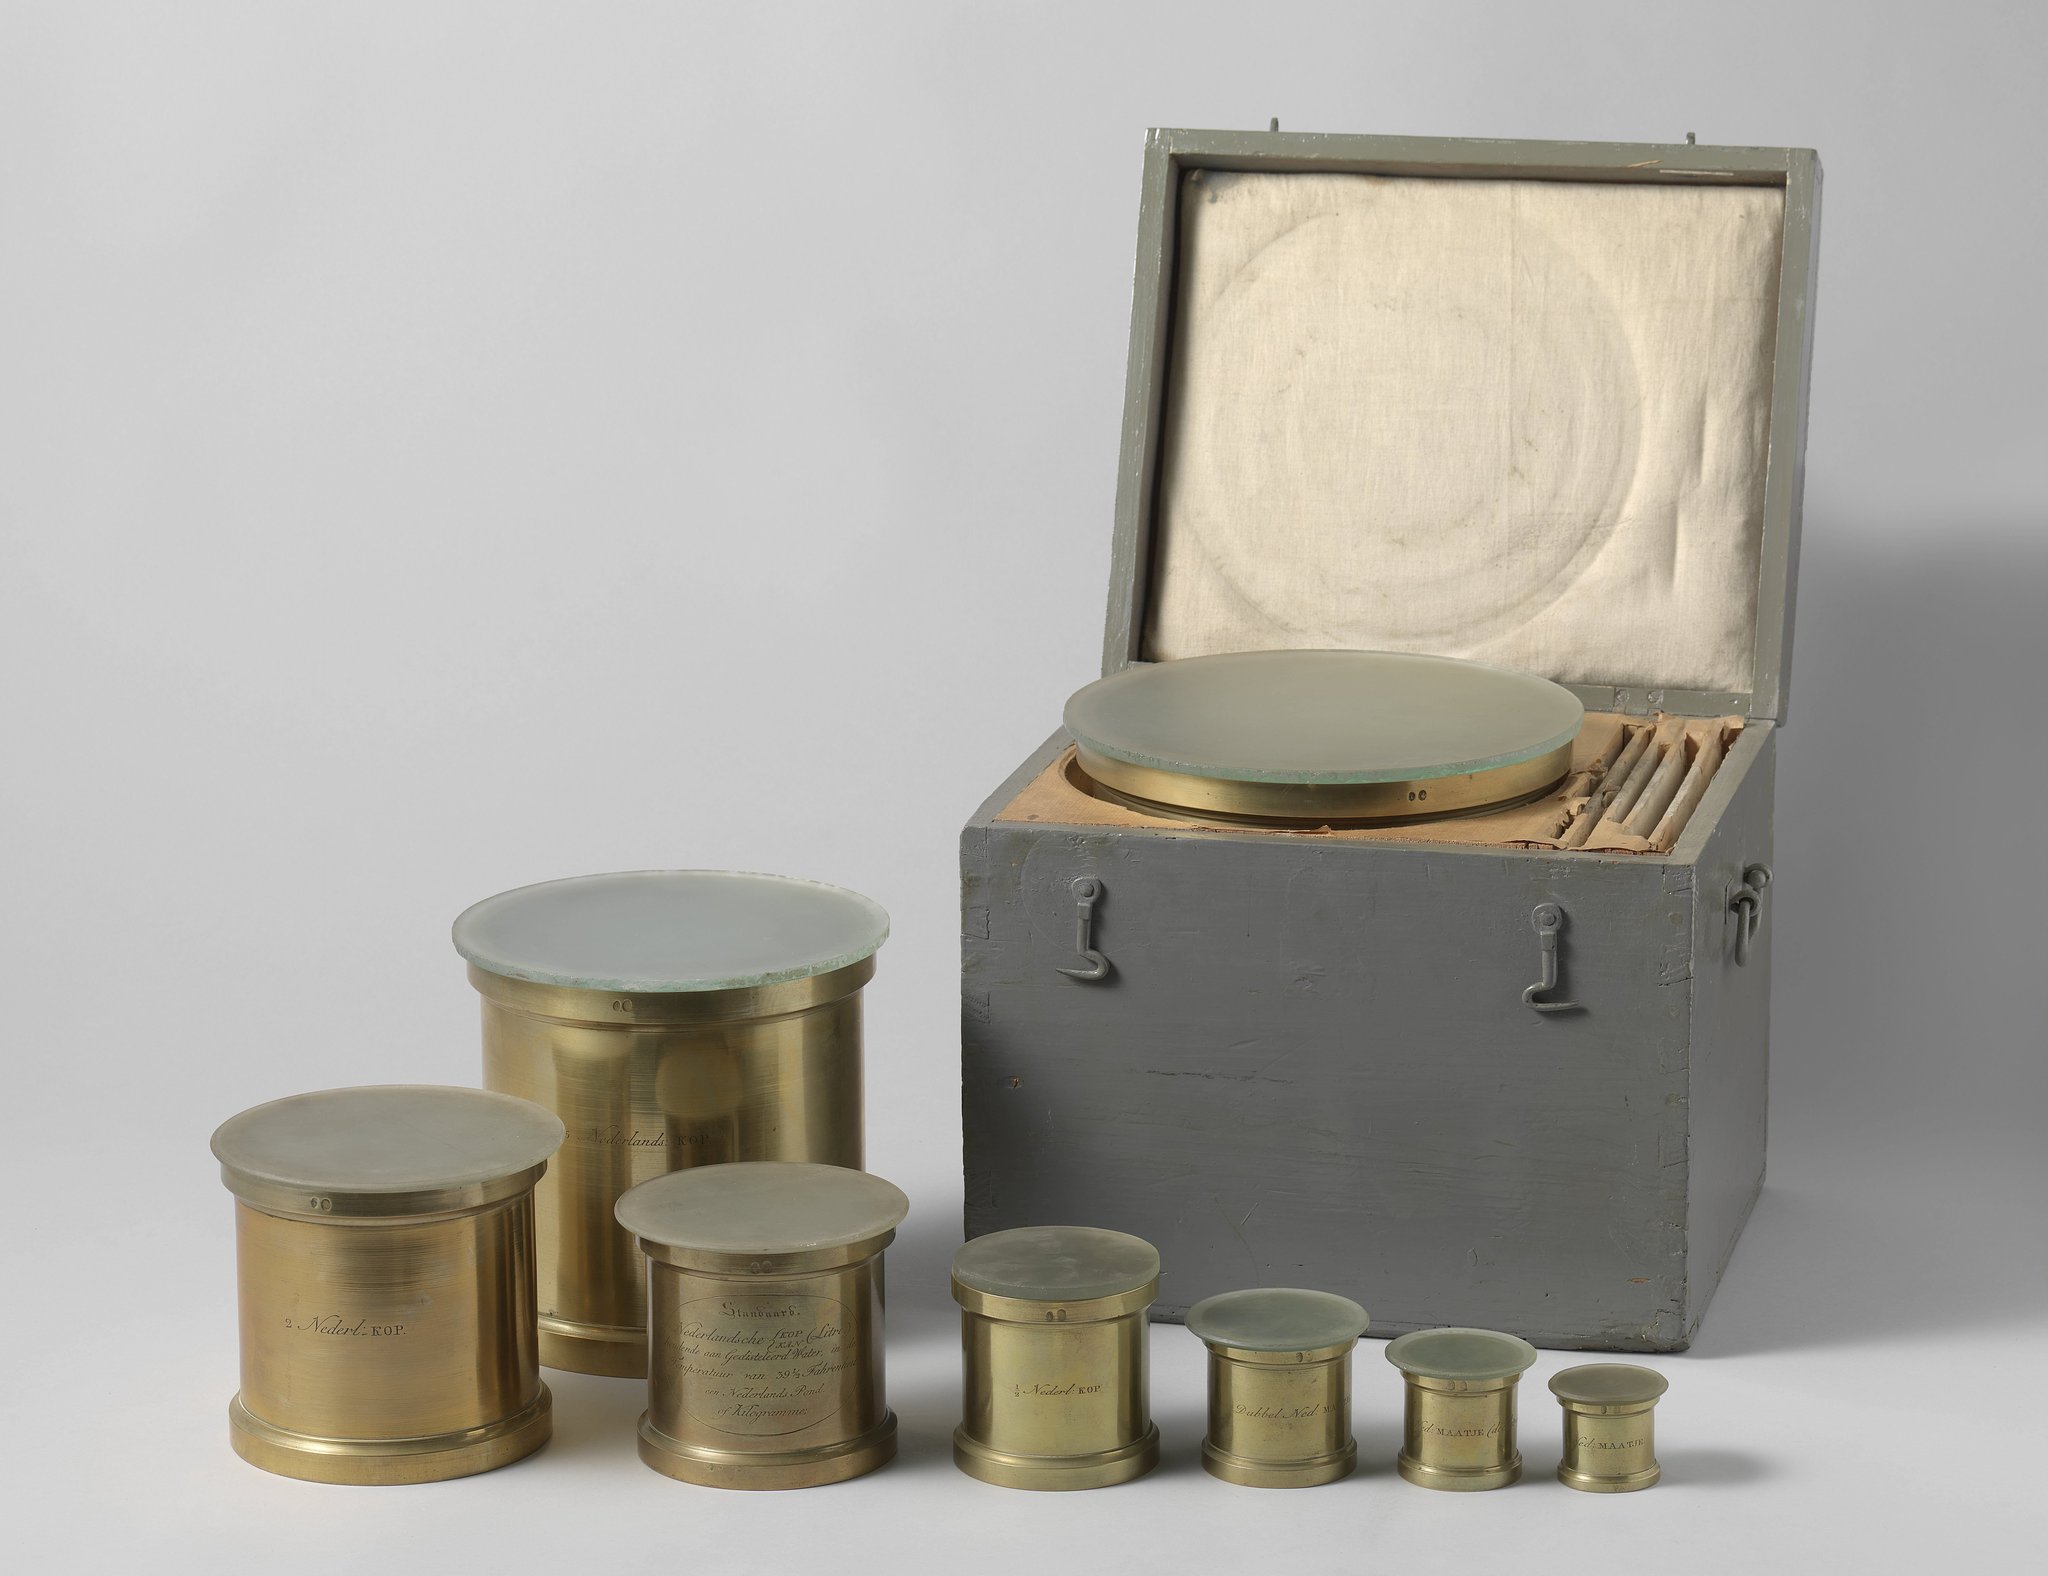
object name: inhoudsmaat natte waren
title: Standard volume measures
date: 1820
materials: brass, glass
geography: amsterdam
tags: netherlands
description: De acht maten in deze kist vormden lang de Nederlandse standaard voor inhoudsmaten. Matgeslepen dekglaasjes moesten voorkomen dat de inhoud boven de rand van de maat uitkwam. De verificatie van deze maten vond plaats tussen 4 en 7 juli 1820 in de geschut- en klokgieterij van de stad Amsterdam door vier leden van de Eerste Klasse van het Koninklijk Instituut, onder wie Van Swinden. Deze leden en de minister van Binnenlandse Zaken gaven hun goedkeuring door deze te laten stempelen.